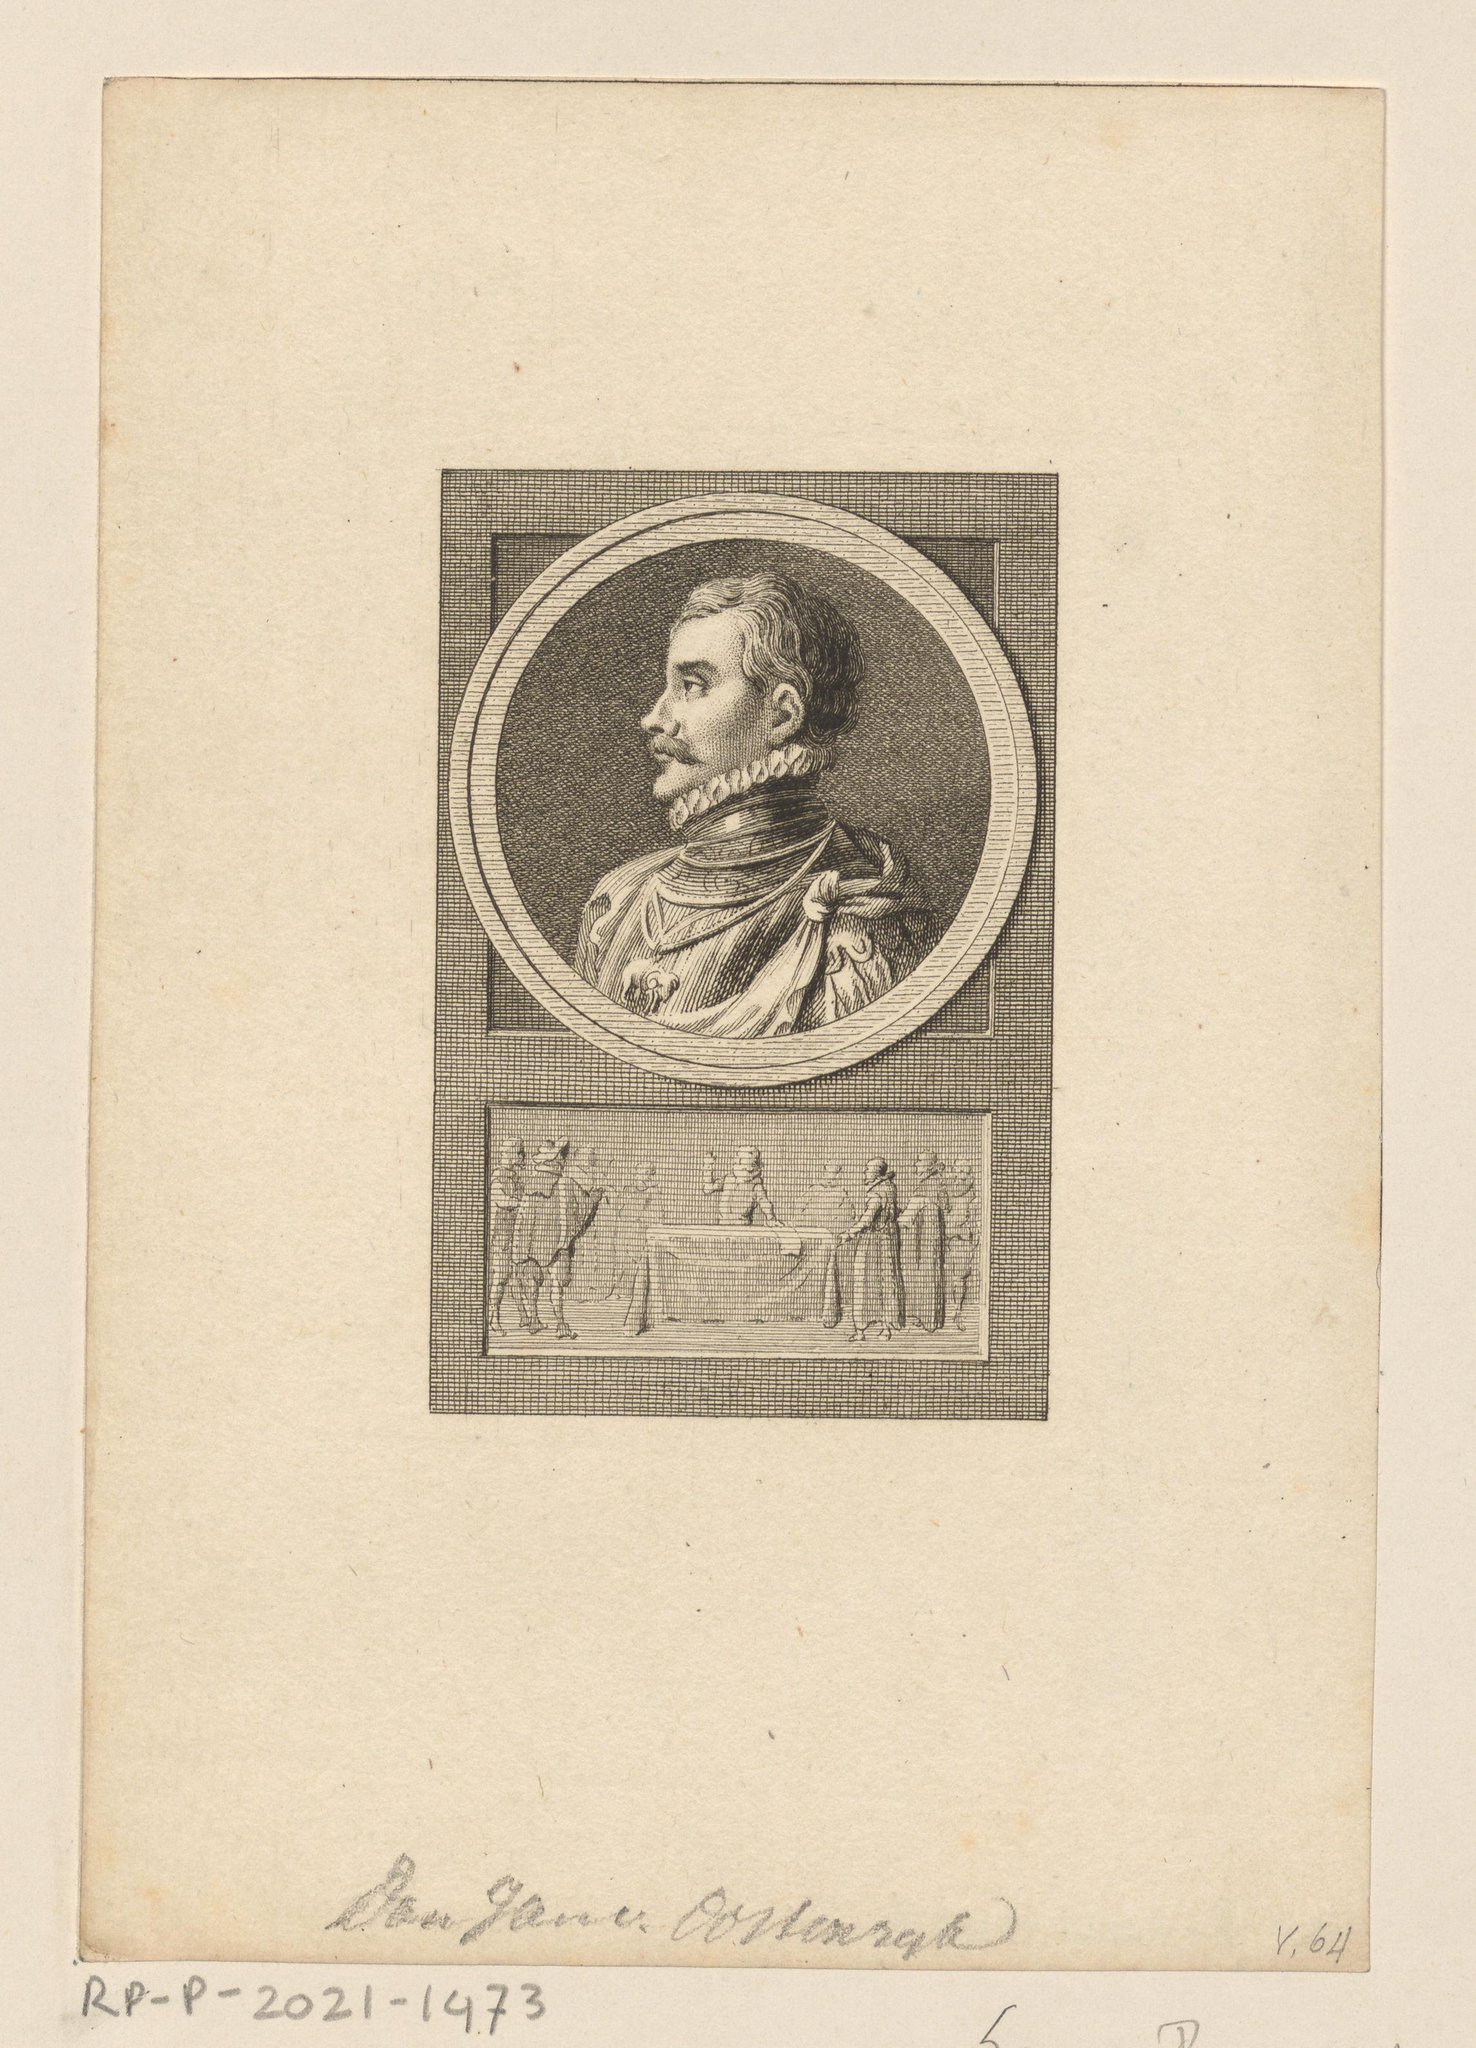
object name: print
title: Portret van Don Juan van Oostenrijk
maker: Anonymous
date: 1700-1799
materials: paper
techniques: etching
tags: don juan van oostenrijk, historical persons, knighthood order of the golden fleece, ruler, sovereign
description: Onder het portret een groep figuren die rondom een man achter een tafel staat.